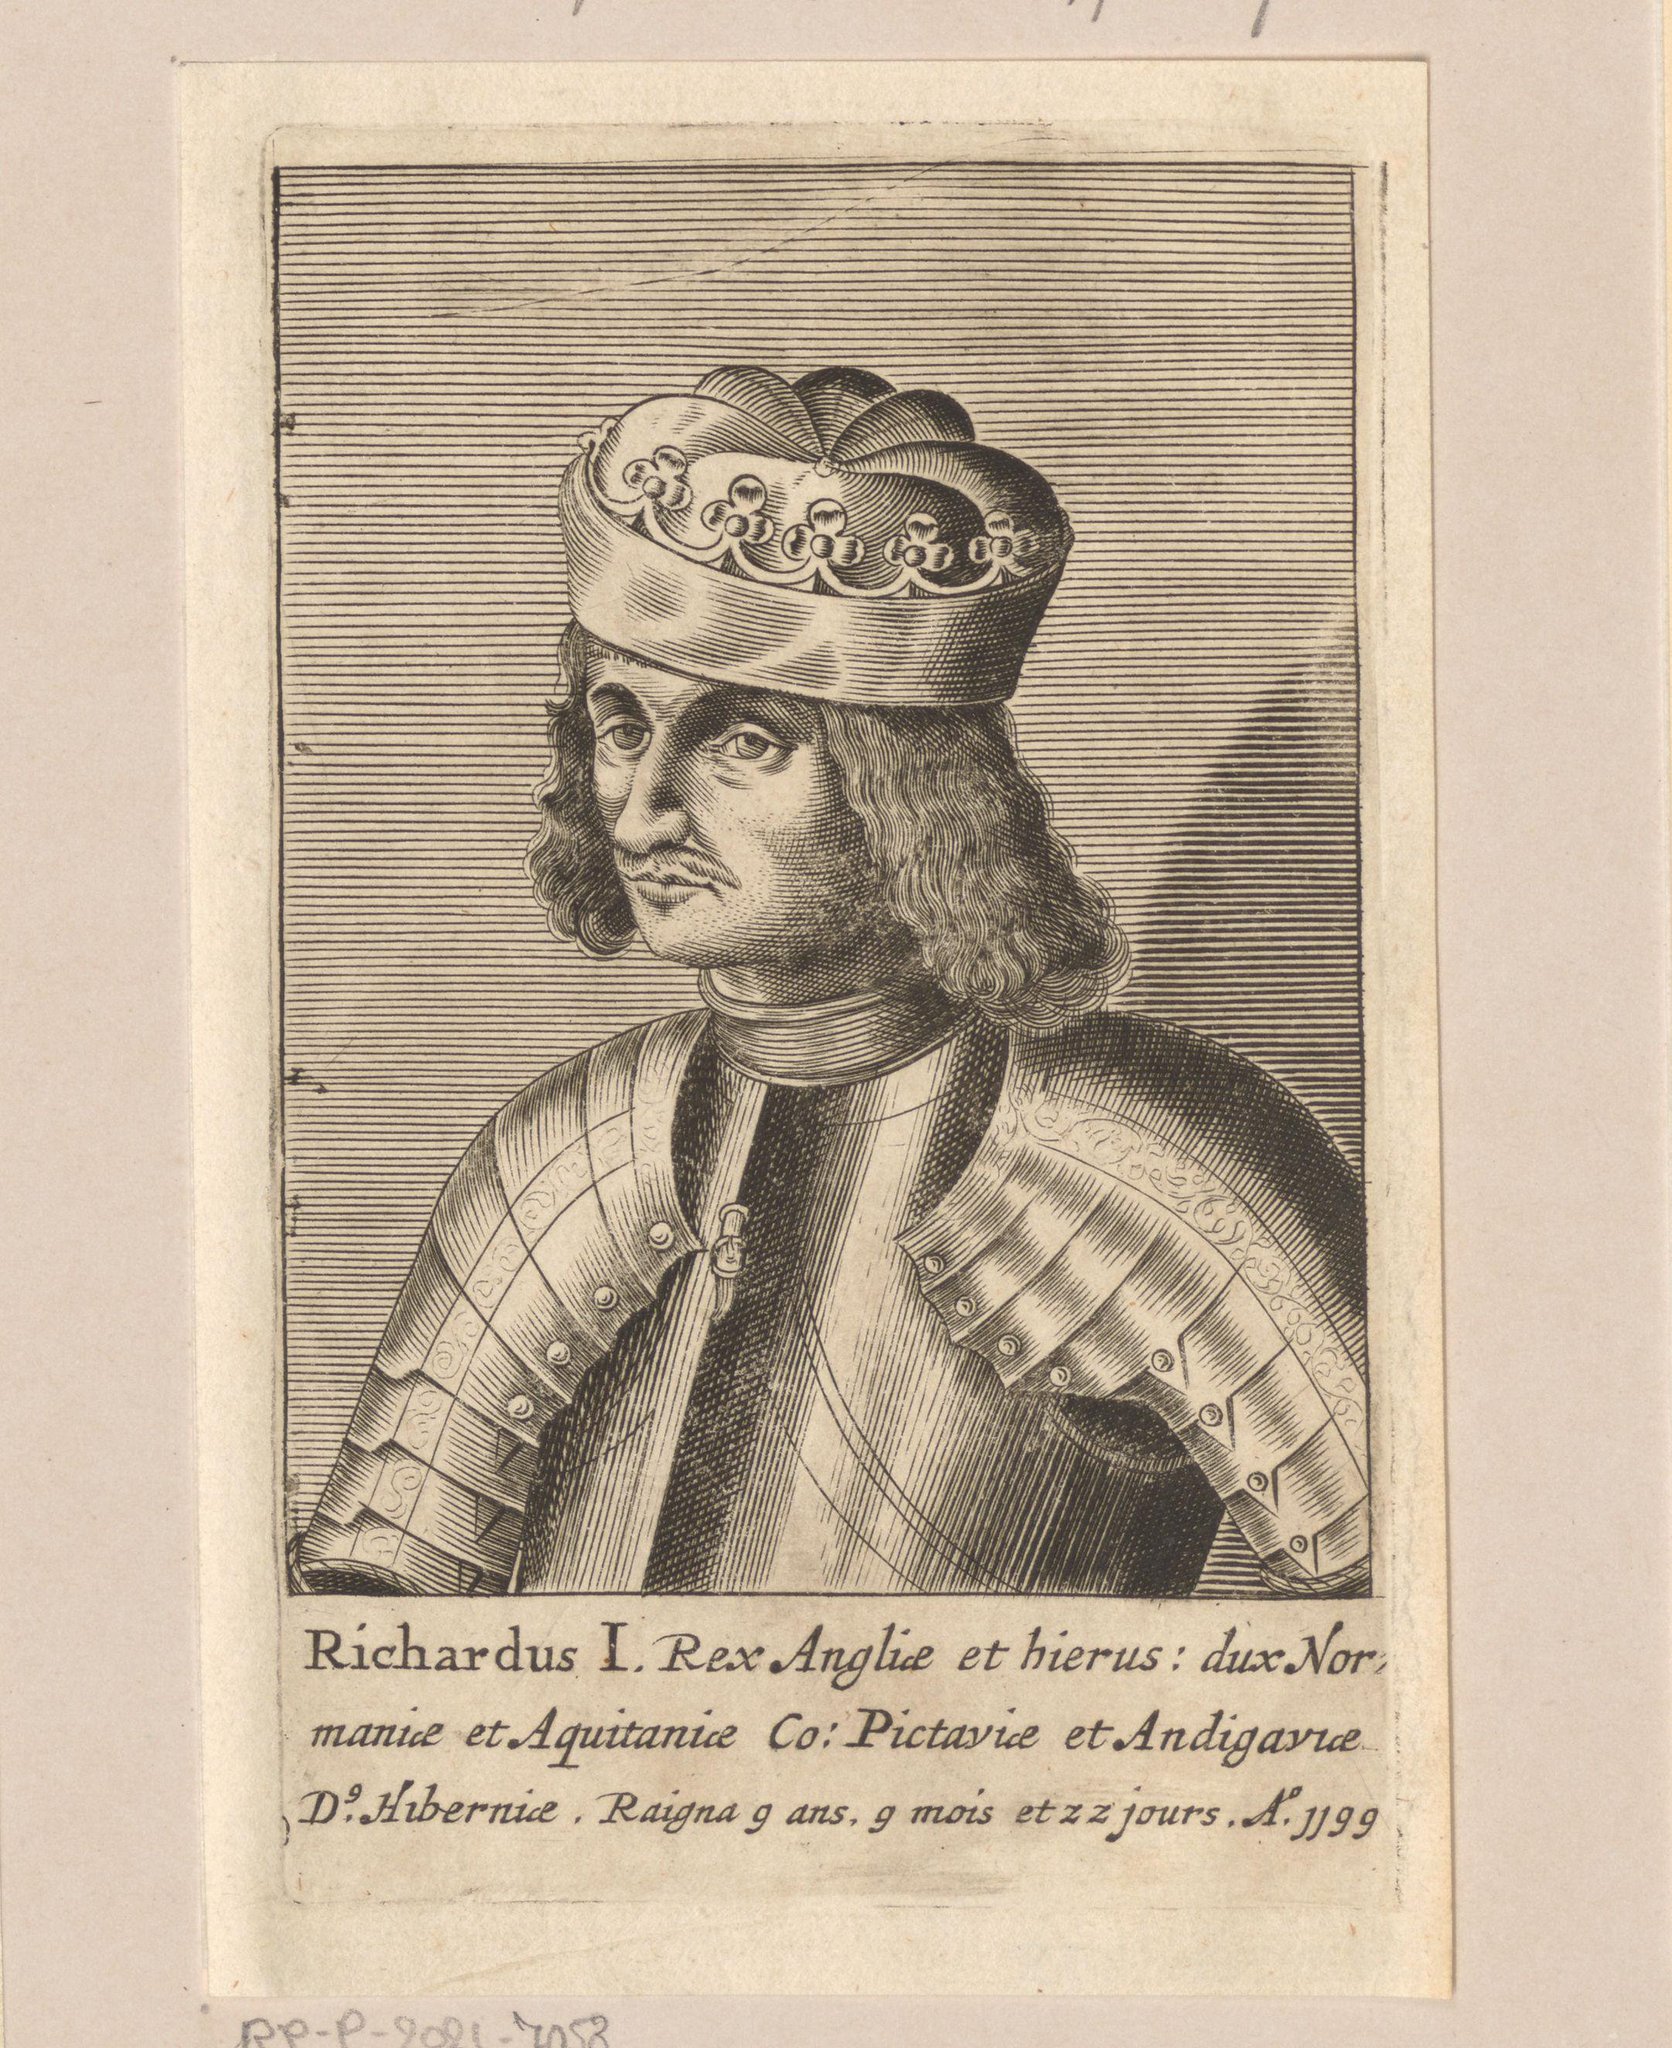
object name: print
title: Portret van Richard I Leeuwenhart, koning van Engeland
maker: Anonymous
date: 1681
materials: paper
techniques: engraving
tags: historical persons, king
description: Prent mogelijk uit: Baker, Sir Richard. Chronyck van het leven en bedrijf van al de koningen van Engelandt (...). Amsterdam: weduwe Jan Jacobsz Schipper, 1681, dl. 1.